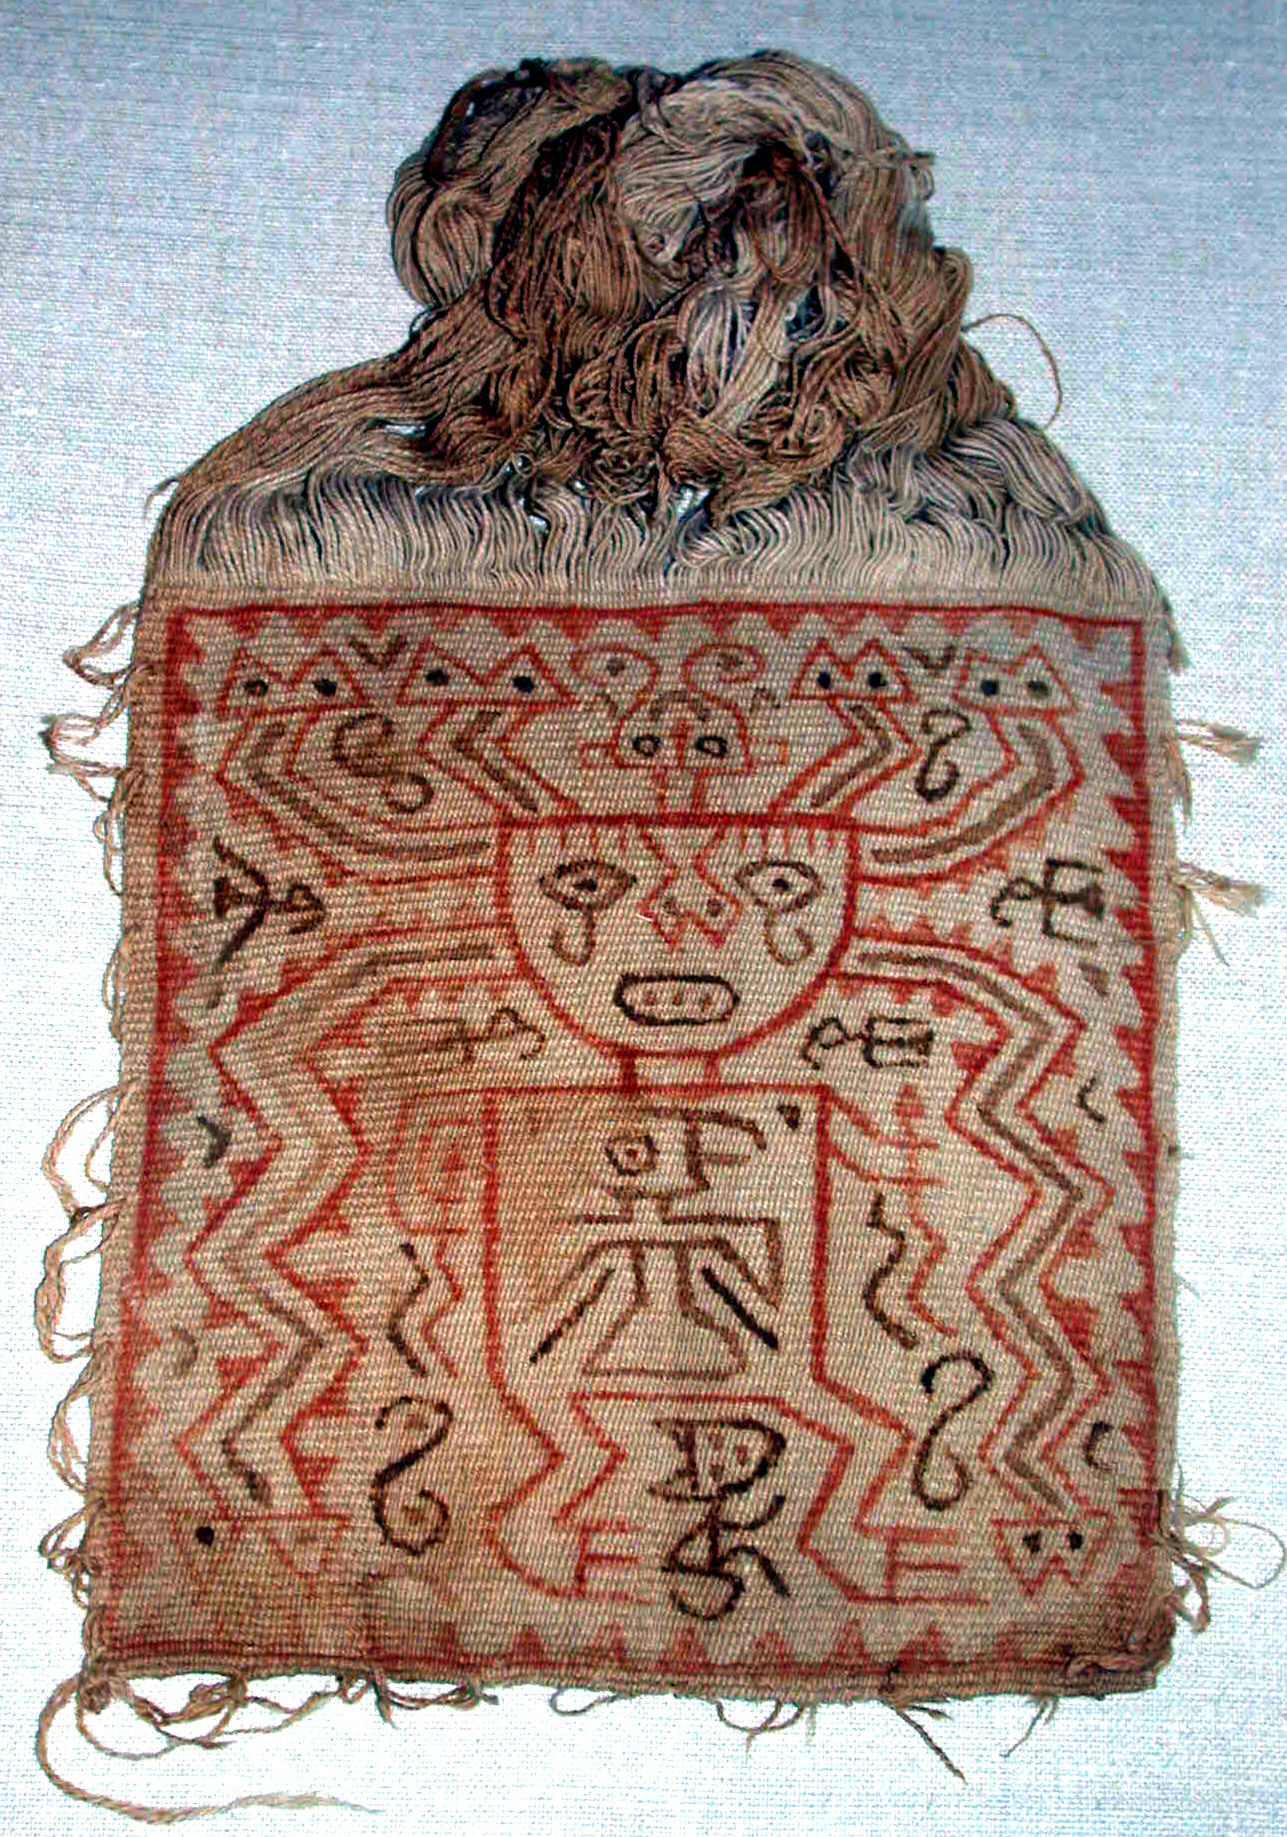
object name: mask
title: False Face for Funerary Bundle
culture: paracas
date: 300 BCE-100 CE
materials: cotton, paint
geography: peru